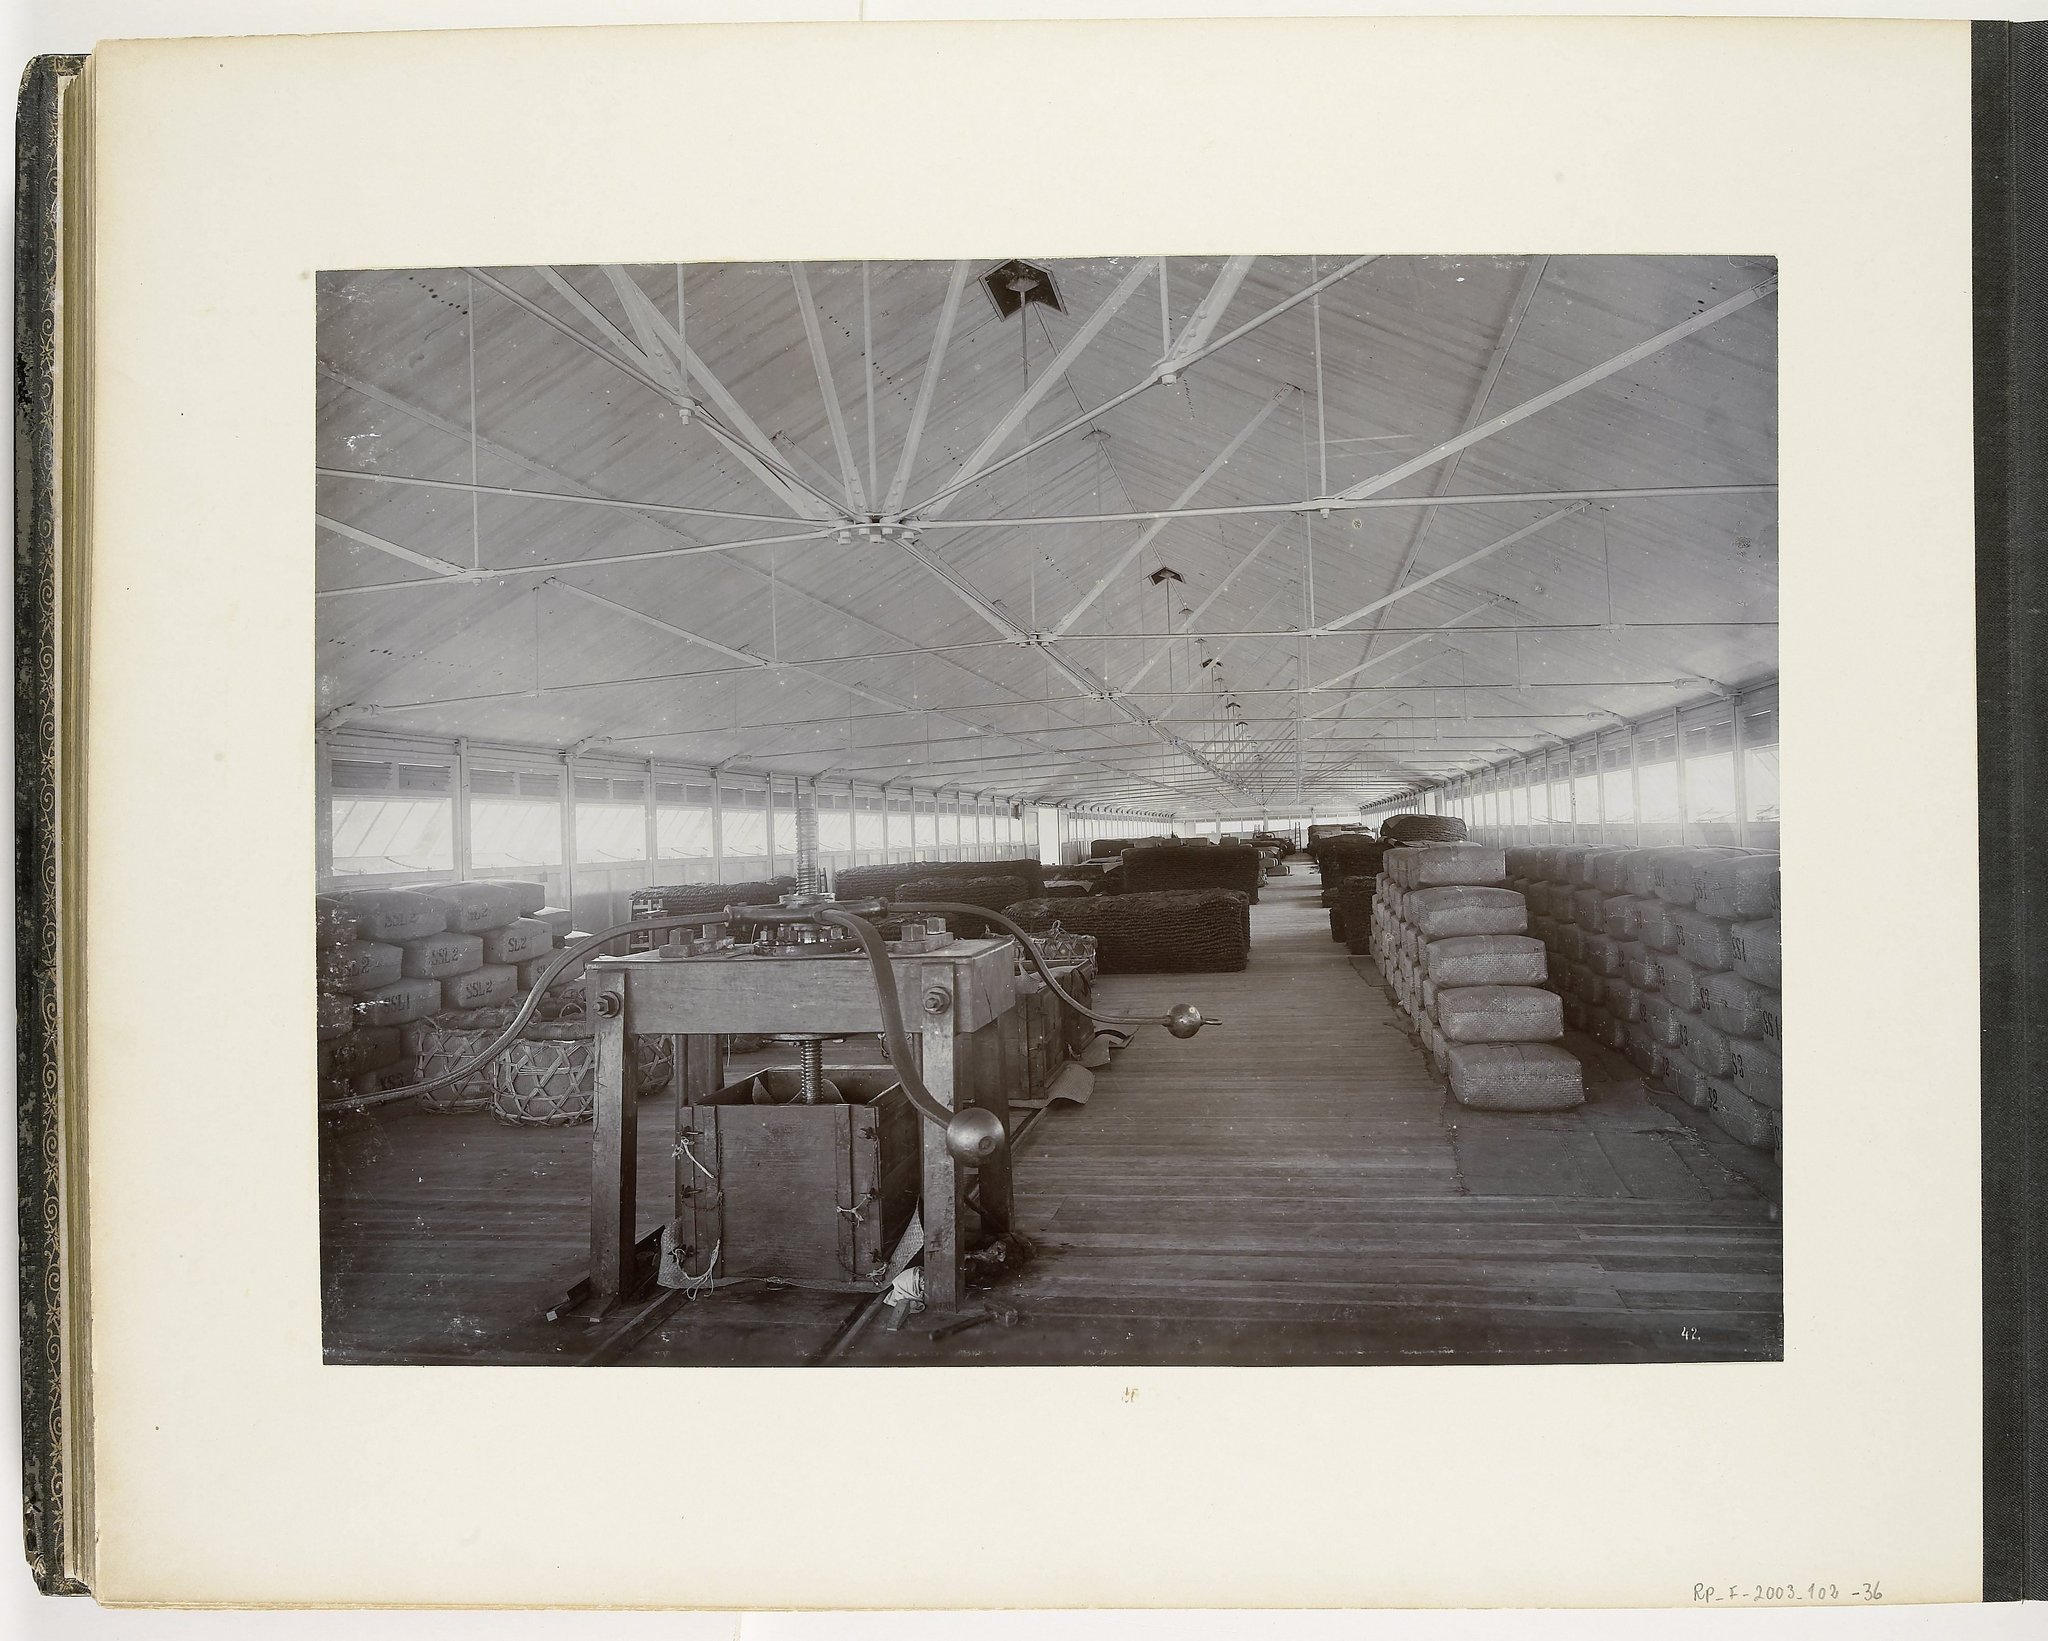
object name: photograph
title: Interieur van de fermenteerschuur met tabakpersen, Padang Tjermin Sumatra (Fermentierscheune Interieur Taback Pressen Pdg. Tjermin)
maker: carl j. kleingrothe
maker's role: fotograaf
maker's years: 1864-1925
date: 1885-1900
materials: photographic support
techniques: collodion silver print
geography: sumatra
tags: sumatra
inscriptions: number: ‘42’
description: Interieur van een schuur van de landbouwonderneming Padang Tjermin in Boven-Langkat met een tabakpers en balen tabak klaar voor verzending. Onderdeel van het Sumatra fotoalbum van Paul en Lucie Sandel uit 1900.